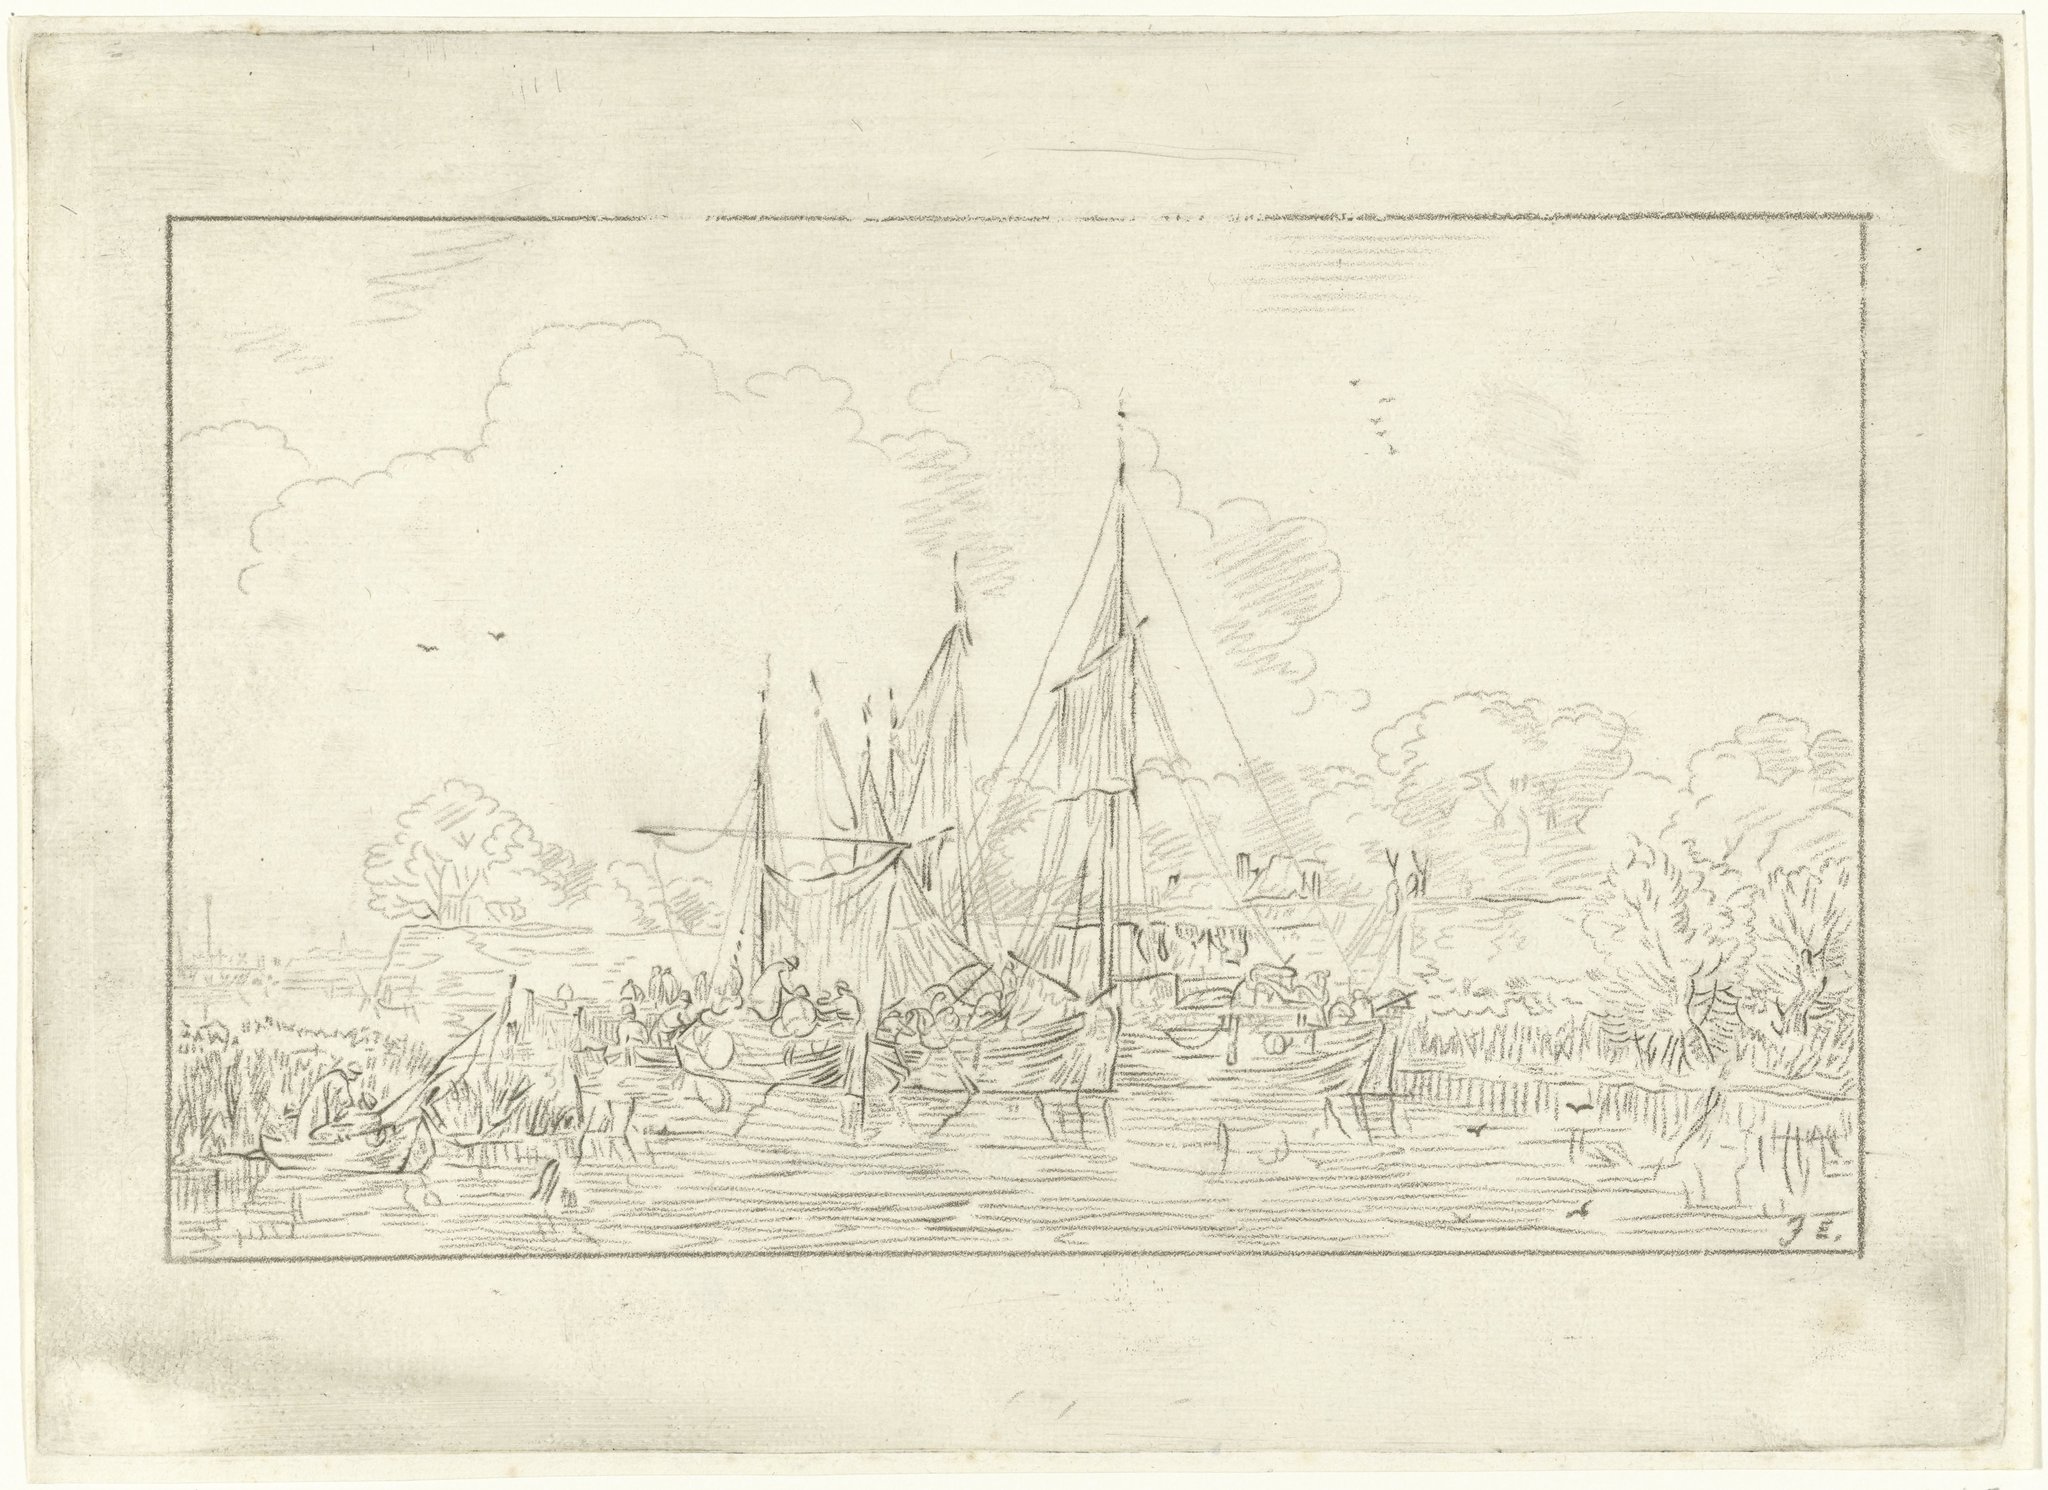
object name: print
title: Riviergezicht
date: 1771-1787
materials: paper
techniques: transfer, print drawing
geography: amsterdam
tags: sailing-ship, sailing-boat, river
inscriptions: collector's mark: Lugt 240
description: Riviergezicht met verschillende zeilschepen en sloepen, die naast elkaar voor anker liggen.